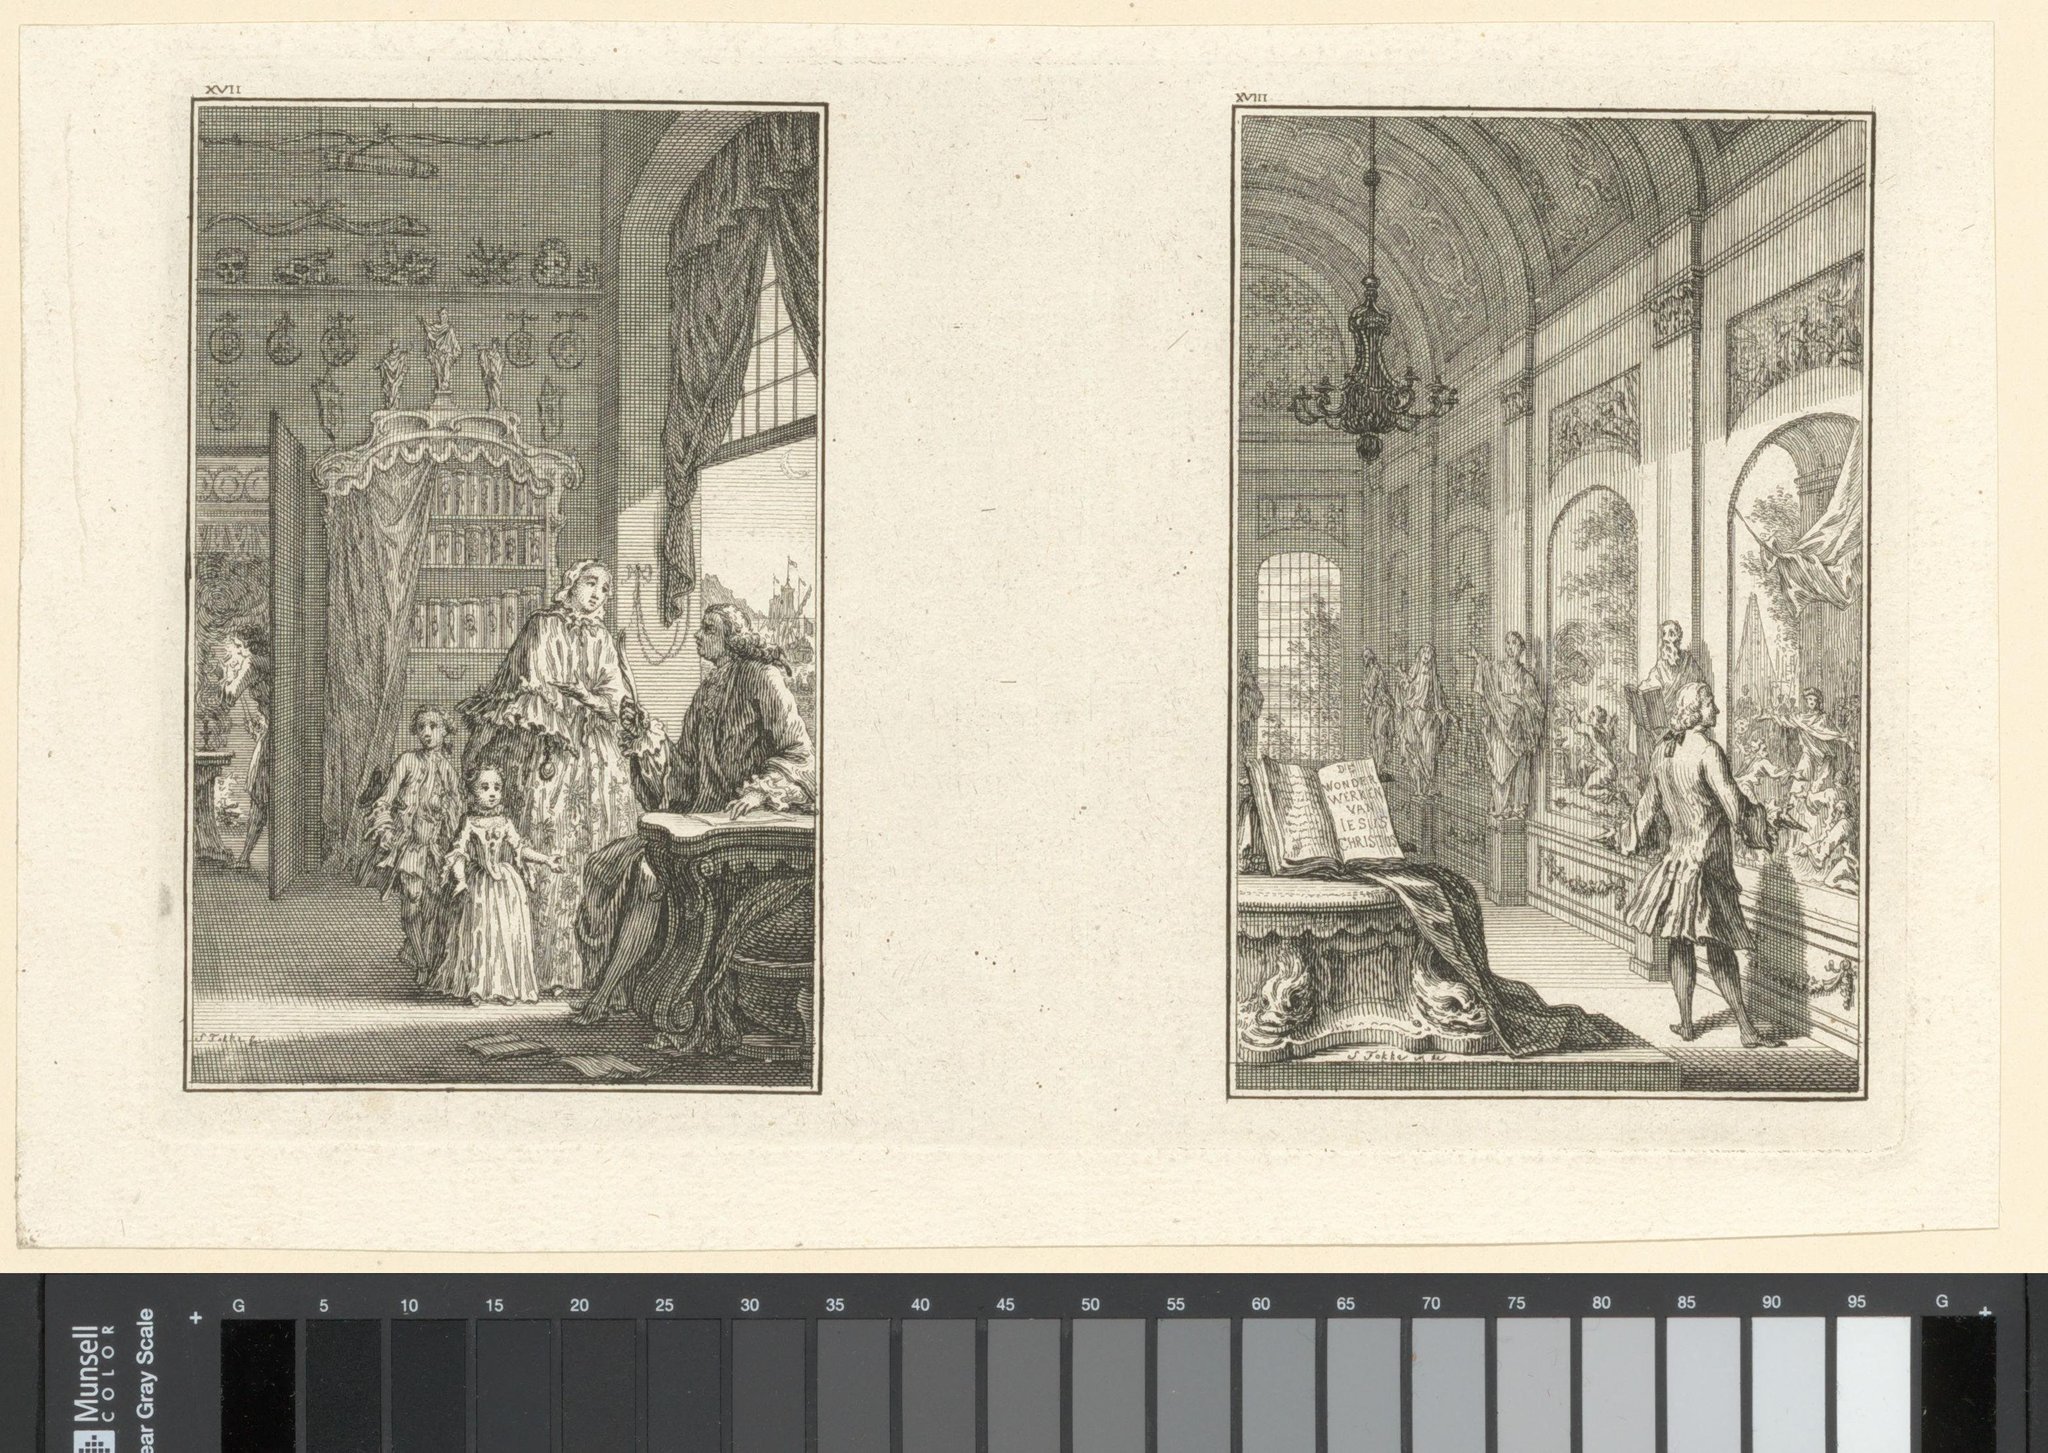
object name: print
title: Kunst en naturalia in een huis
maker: simon fokke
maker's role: draughtsman, print maker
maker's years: 1712-1784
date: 1722-1784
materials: paper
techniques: etching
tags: interior of the house, picture, painting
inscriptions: collector's mark: Lugt 1641, stamp, stamp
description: Twee voorstellingen van een plaat. Links een vrouw met twee kinderen staan bij een man aan zijn bureau. Op de achtergrond een kast met organisme op sterk water en erboven verschillende schedels. Rechtsboven deze voorstelling genummerd: XVII. Een man die aandachtig wandschilderingen bestudeerd. Rechtsboven de voorstelling genummerd: XVIII. Onderwerpsrubrieken binnen de Atlas Zeden en Gewoonten: Handel, nijverheid en verkeer, Buitenleven.